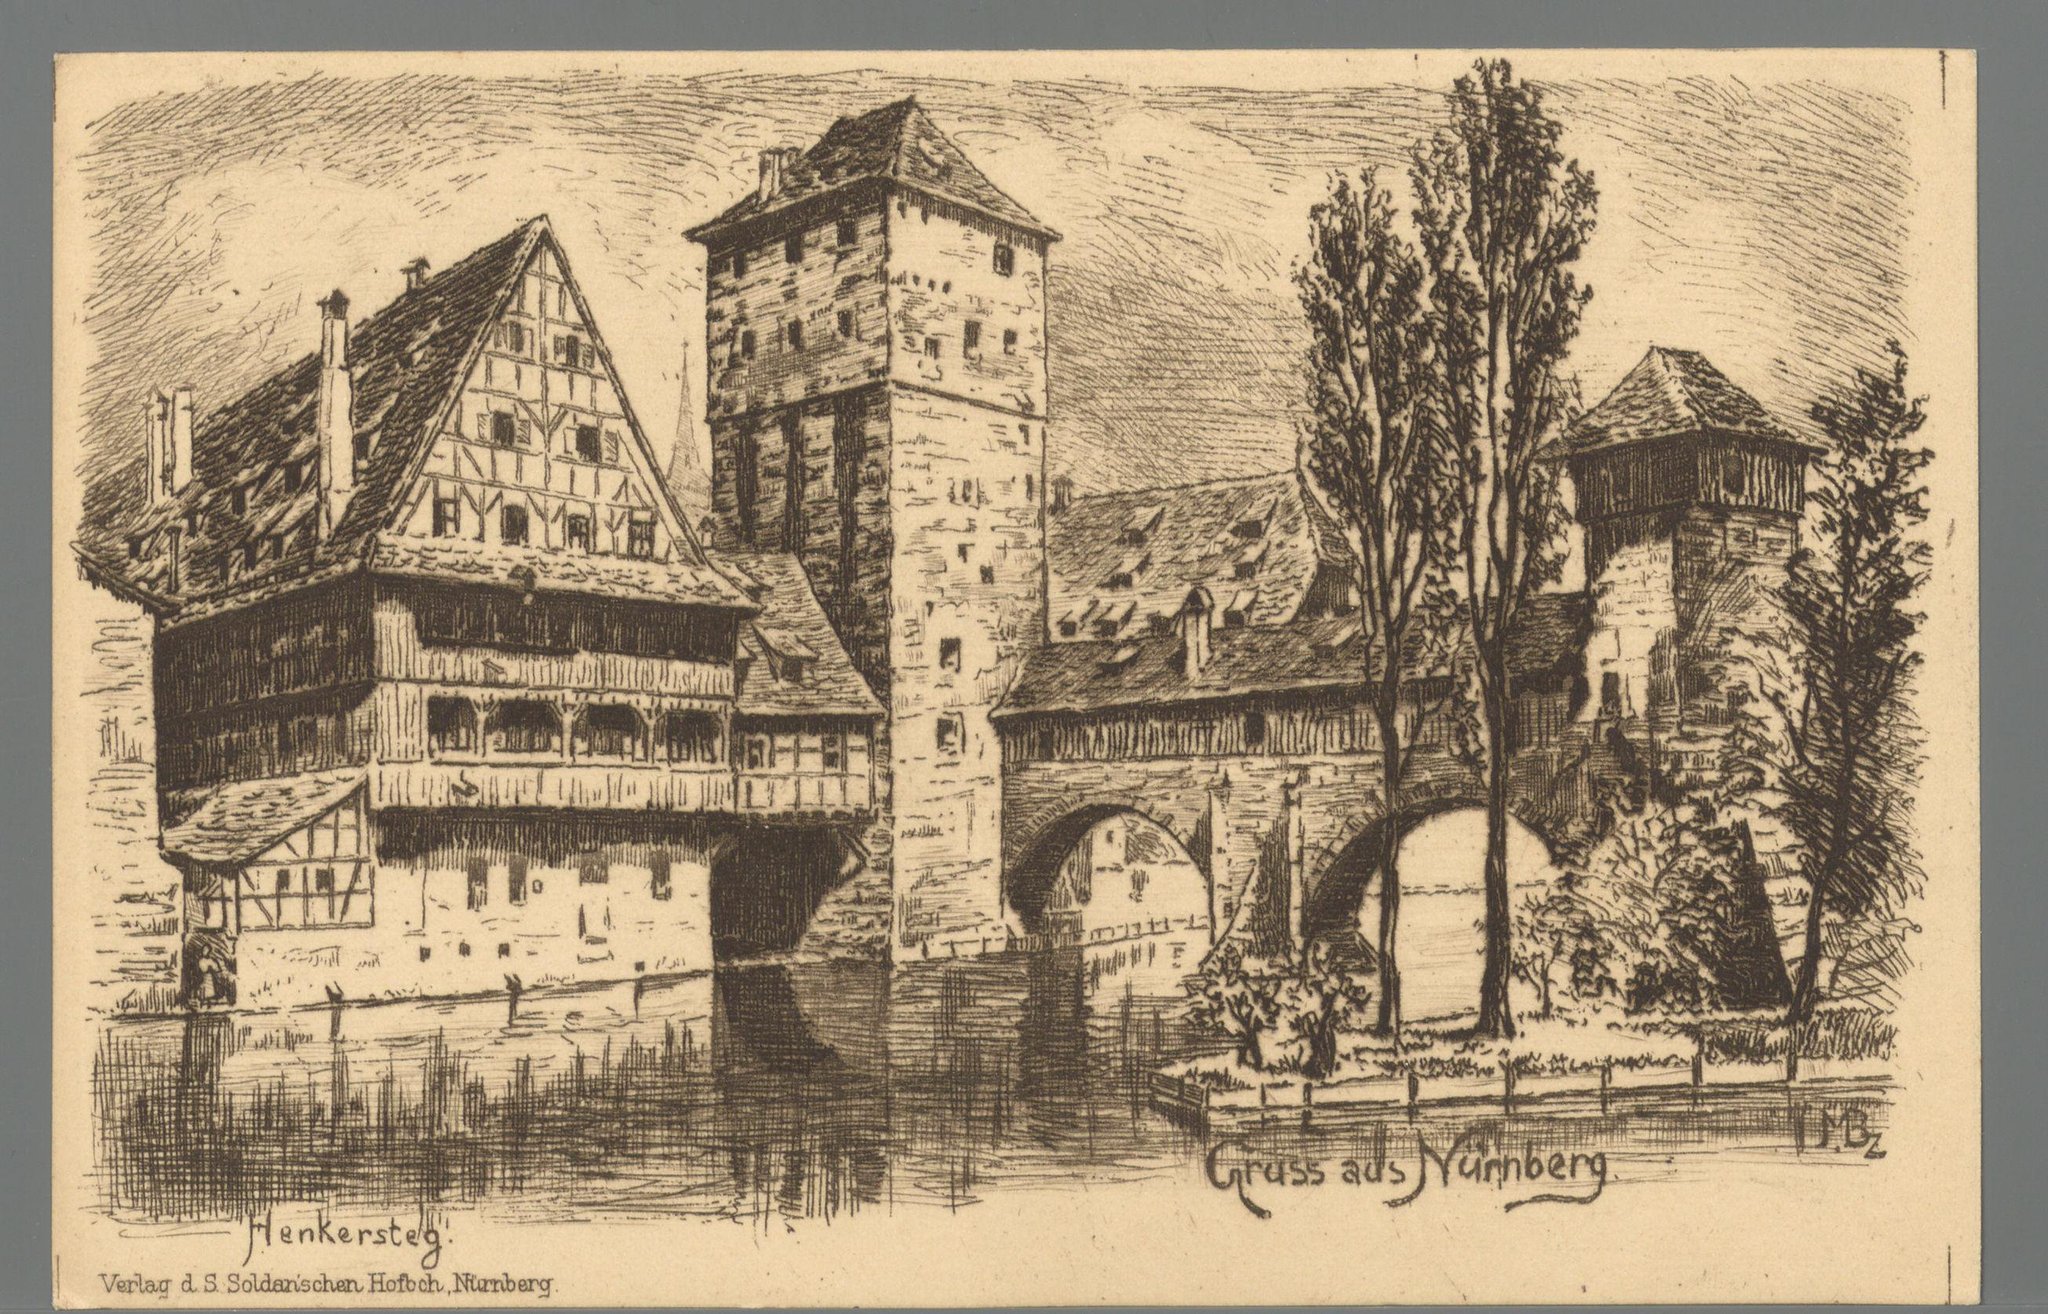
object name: ansichtkaart, prentbriefkaart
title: Henkersteg. Gruss aus Nürnberg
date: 1905-1909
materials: cardboard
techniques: etching, writing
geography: nuremberg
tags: towers ~ fortified city, canals, waters (in city), bridge in city across river, canal, etc.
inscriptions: inscription: ‘MBz’